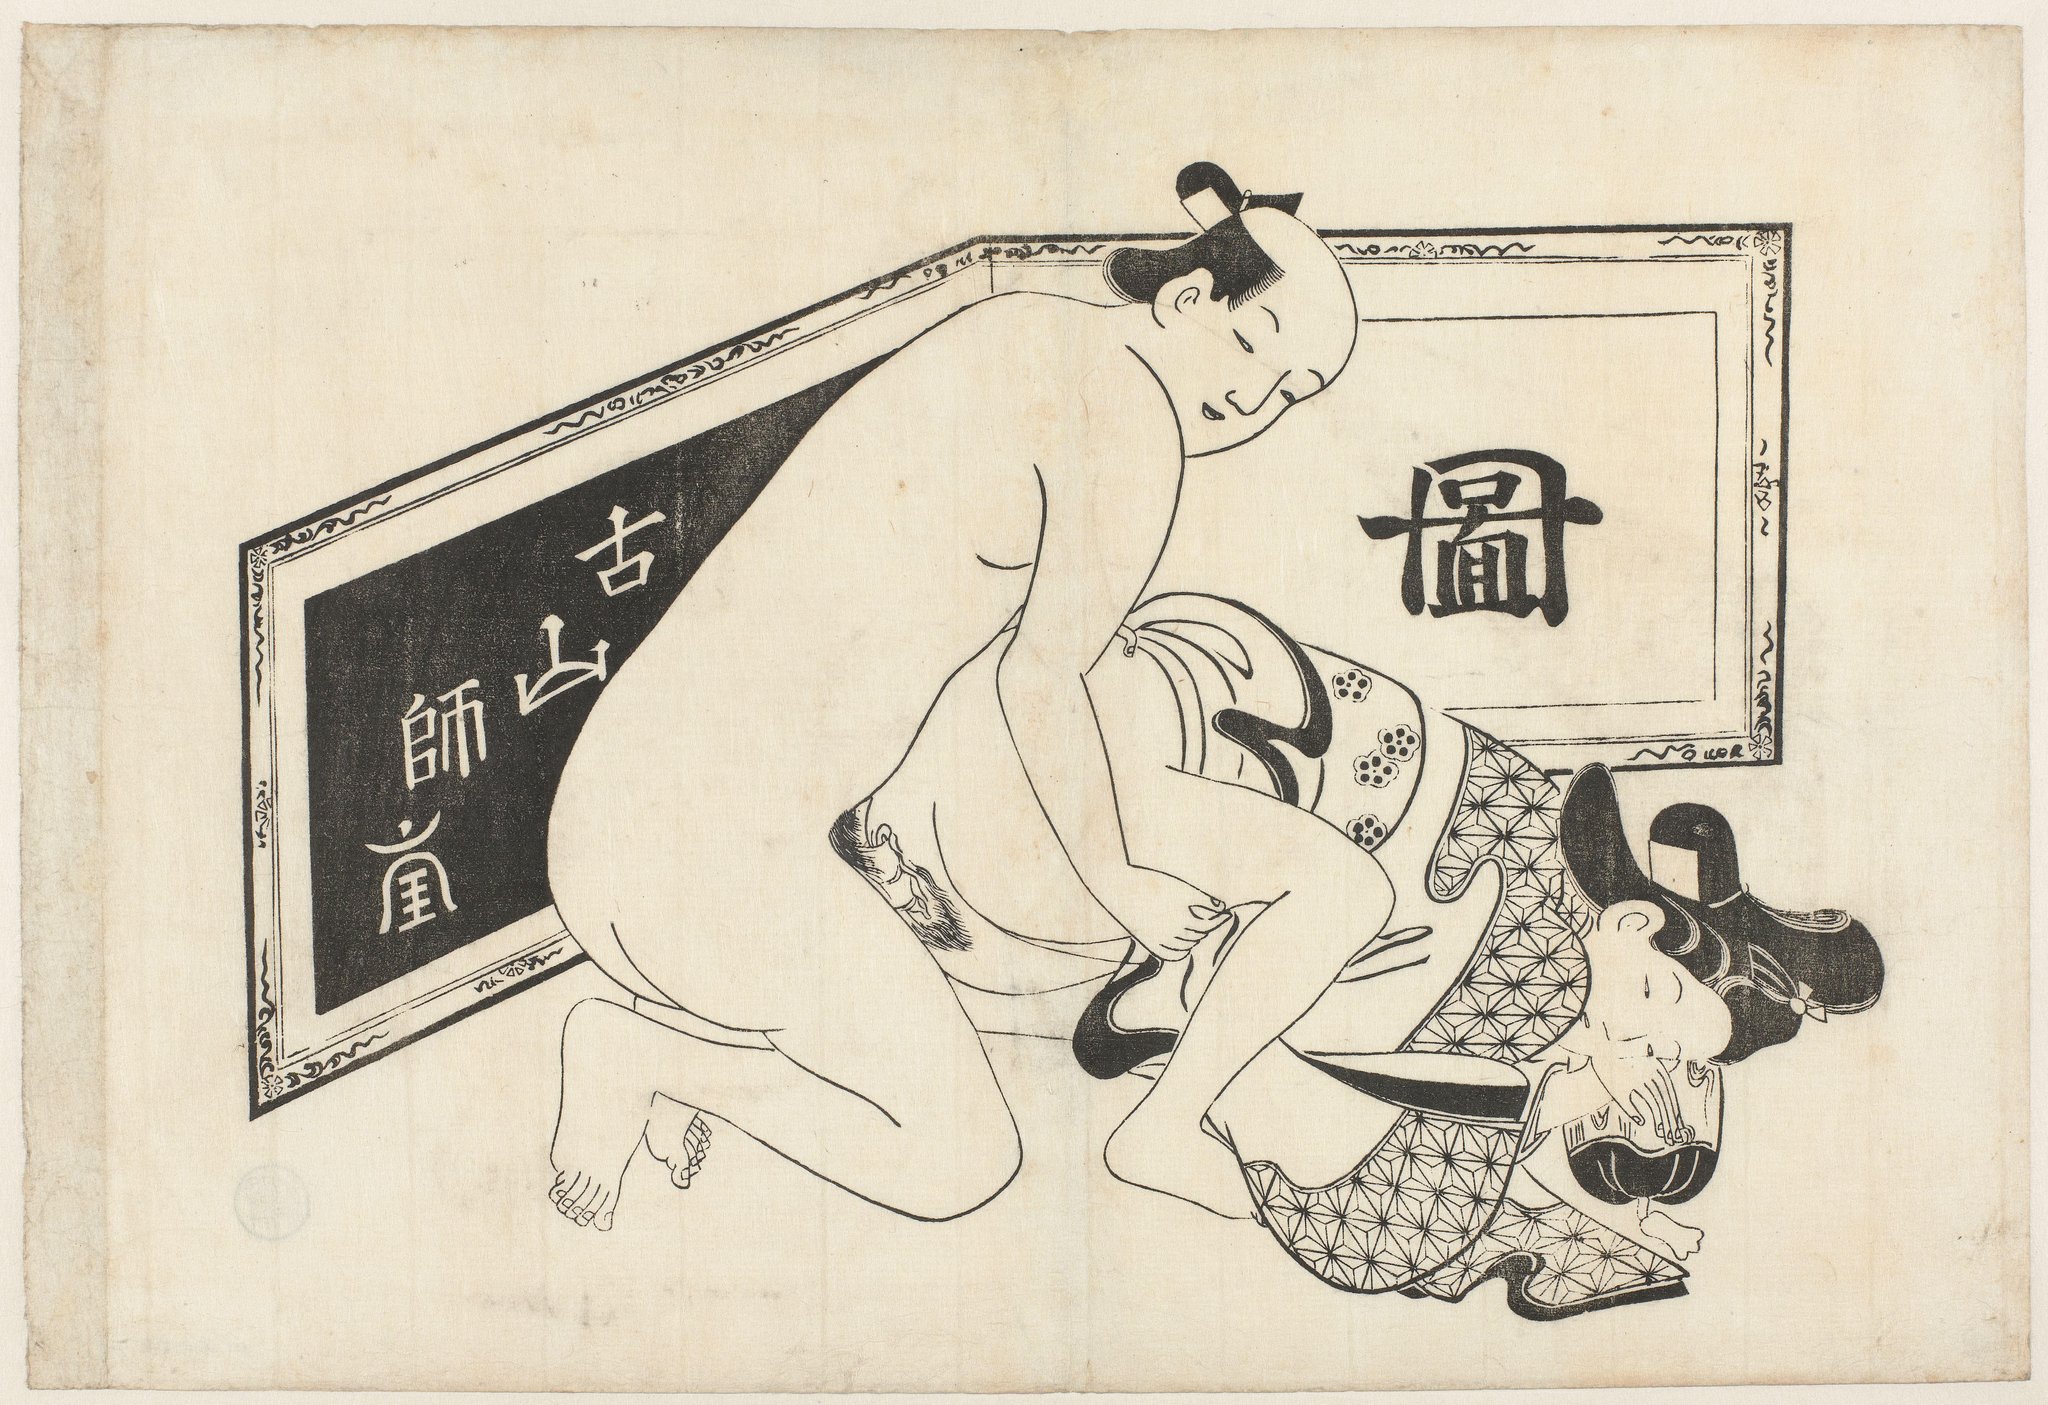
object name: print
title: Erotische voorstelling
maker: hishikawa moroshige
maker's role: print maker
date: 1678-1698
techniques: woodcut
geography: edo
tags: blanket, screen, folding screen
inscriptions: signature: ‘古山師重’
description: Een vrijend paar naast een laag kamerscherm. Op het kamerscherm is de naam van de kunstenaar te lezen: Furuyama Moroshige (古山師重).